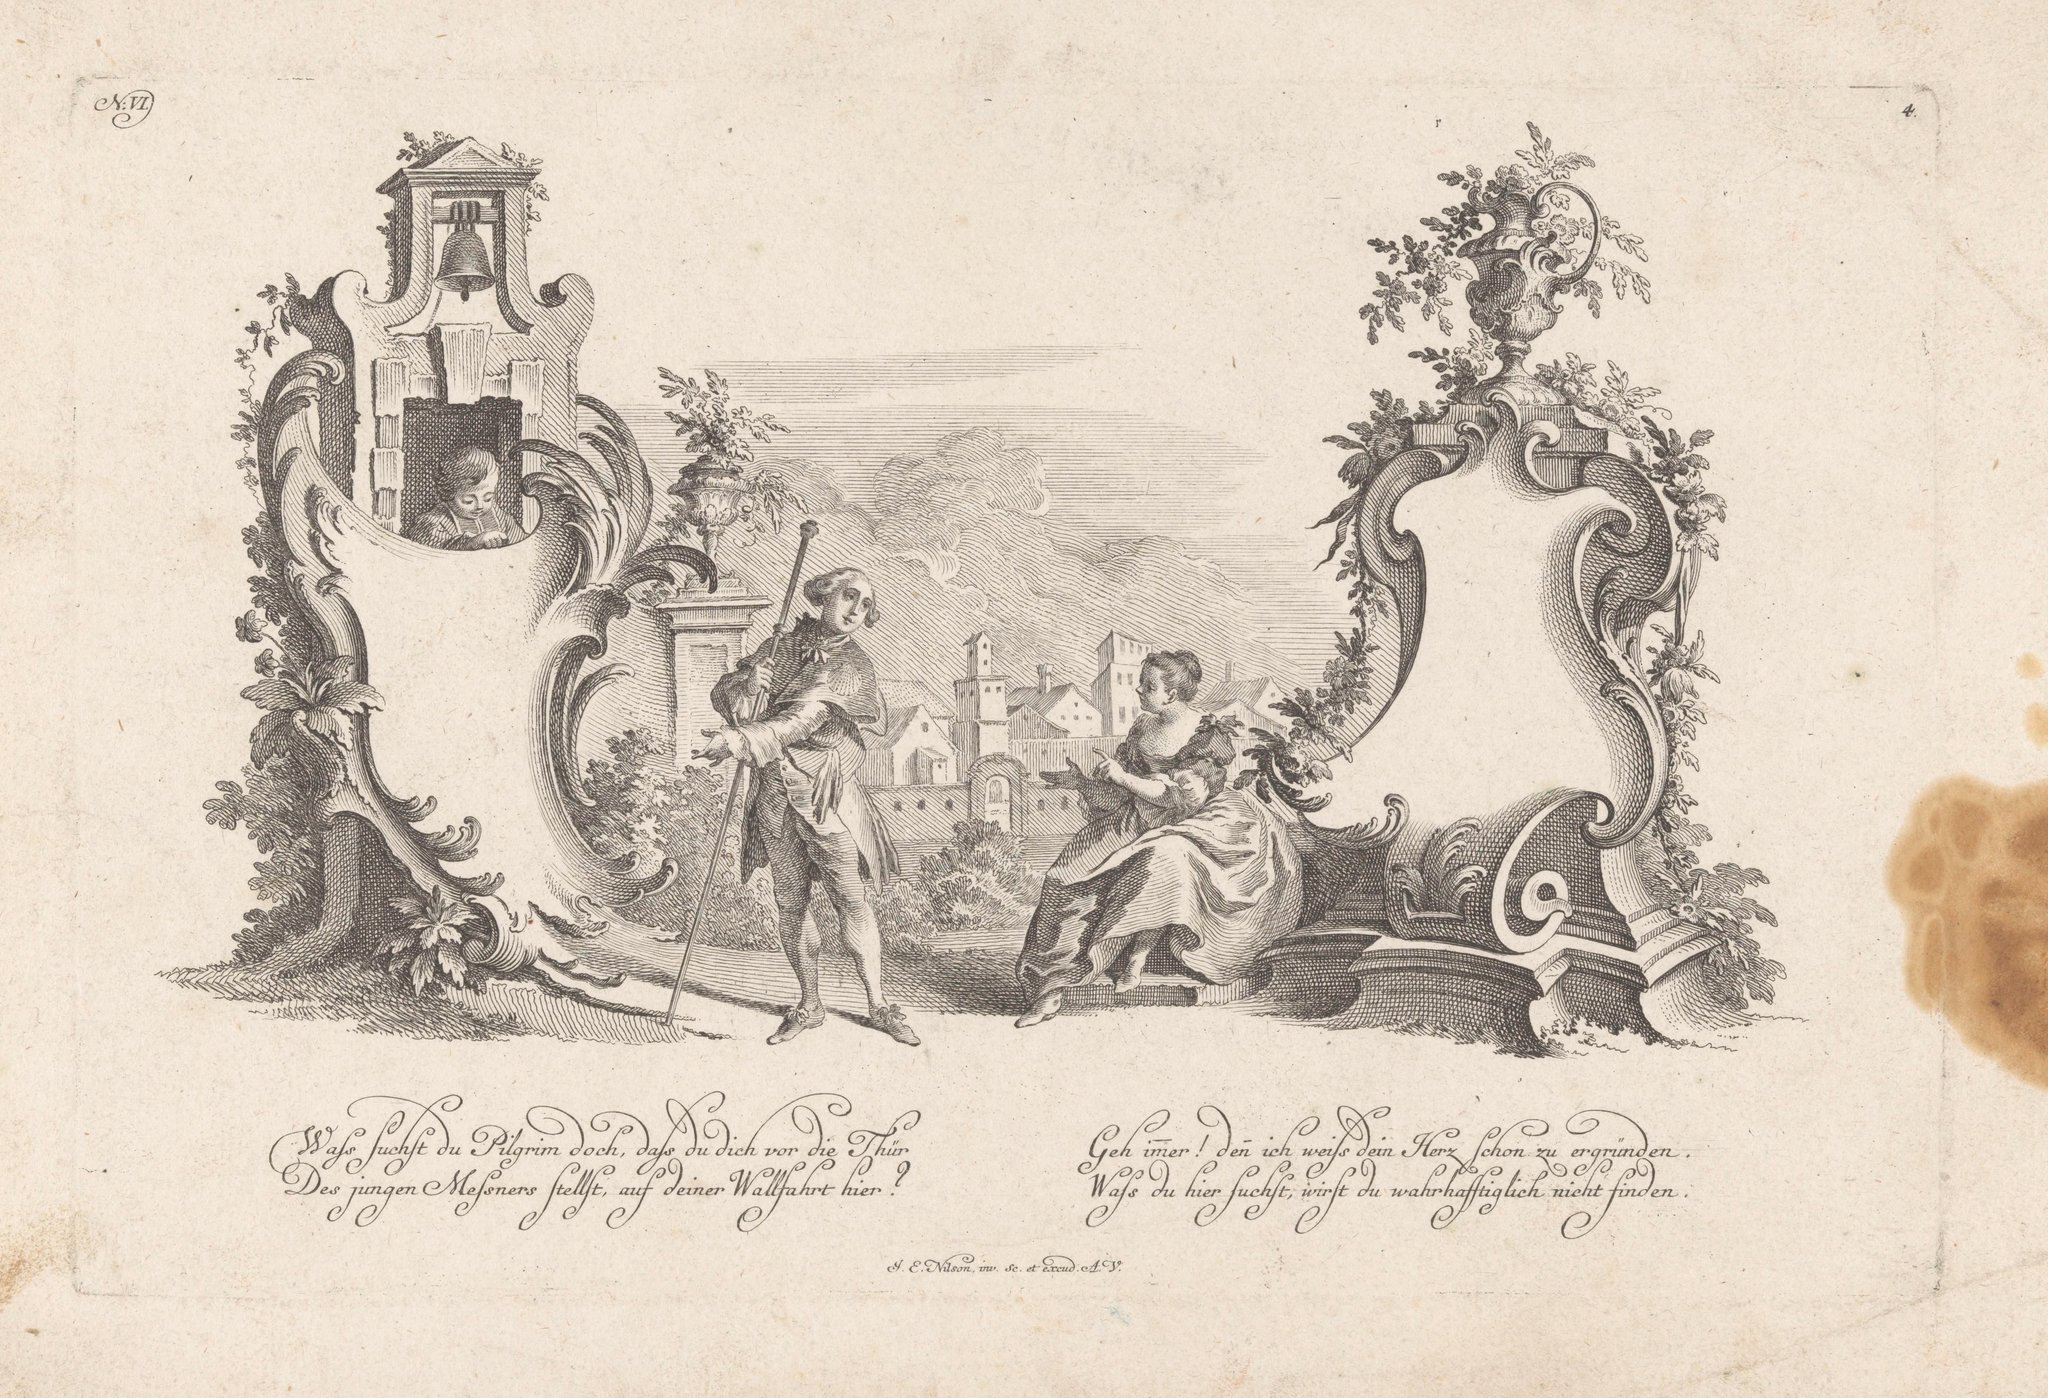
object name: ornament print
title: Cartouches met pelgrim en vrouw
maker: johann esaias nilson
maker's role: draughtsman, print maker, publisher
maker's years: 1721-1788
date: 1731-1788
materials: paper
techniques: engraving, etching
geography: augsburg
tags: parts of church exterior and annexes: campanile, pilgrim(s), ornament ~ cartouche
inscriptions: collector's mark: Lugt 2760, collector's mark: Lugt 2228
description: Twee rocaille cartouches in een landschap met een stad in de achtergrond. Naast het rechtercartouche zit een vrouw, zij preekt tegen een pelgrim links. Boven het linkercartouche zit een figuur voor een klokkentoren. In de ondermarge twee kolommen met tweeregelige Duitse tekst. Uitgeversnummer VI.